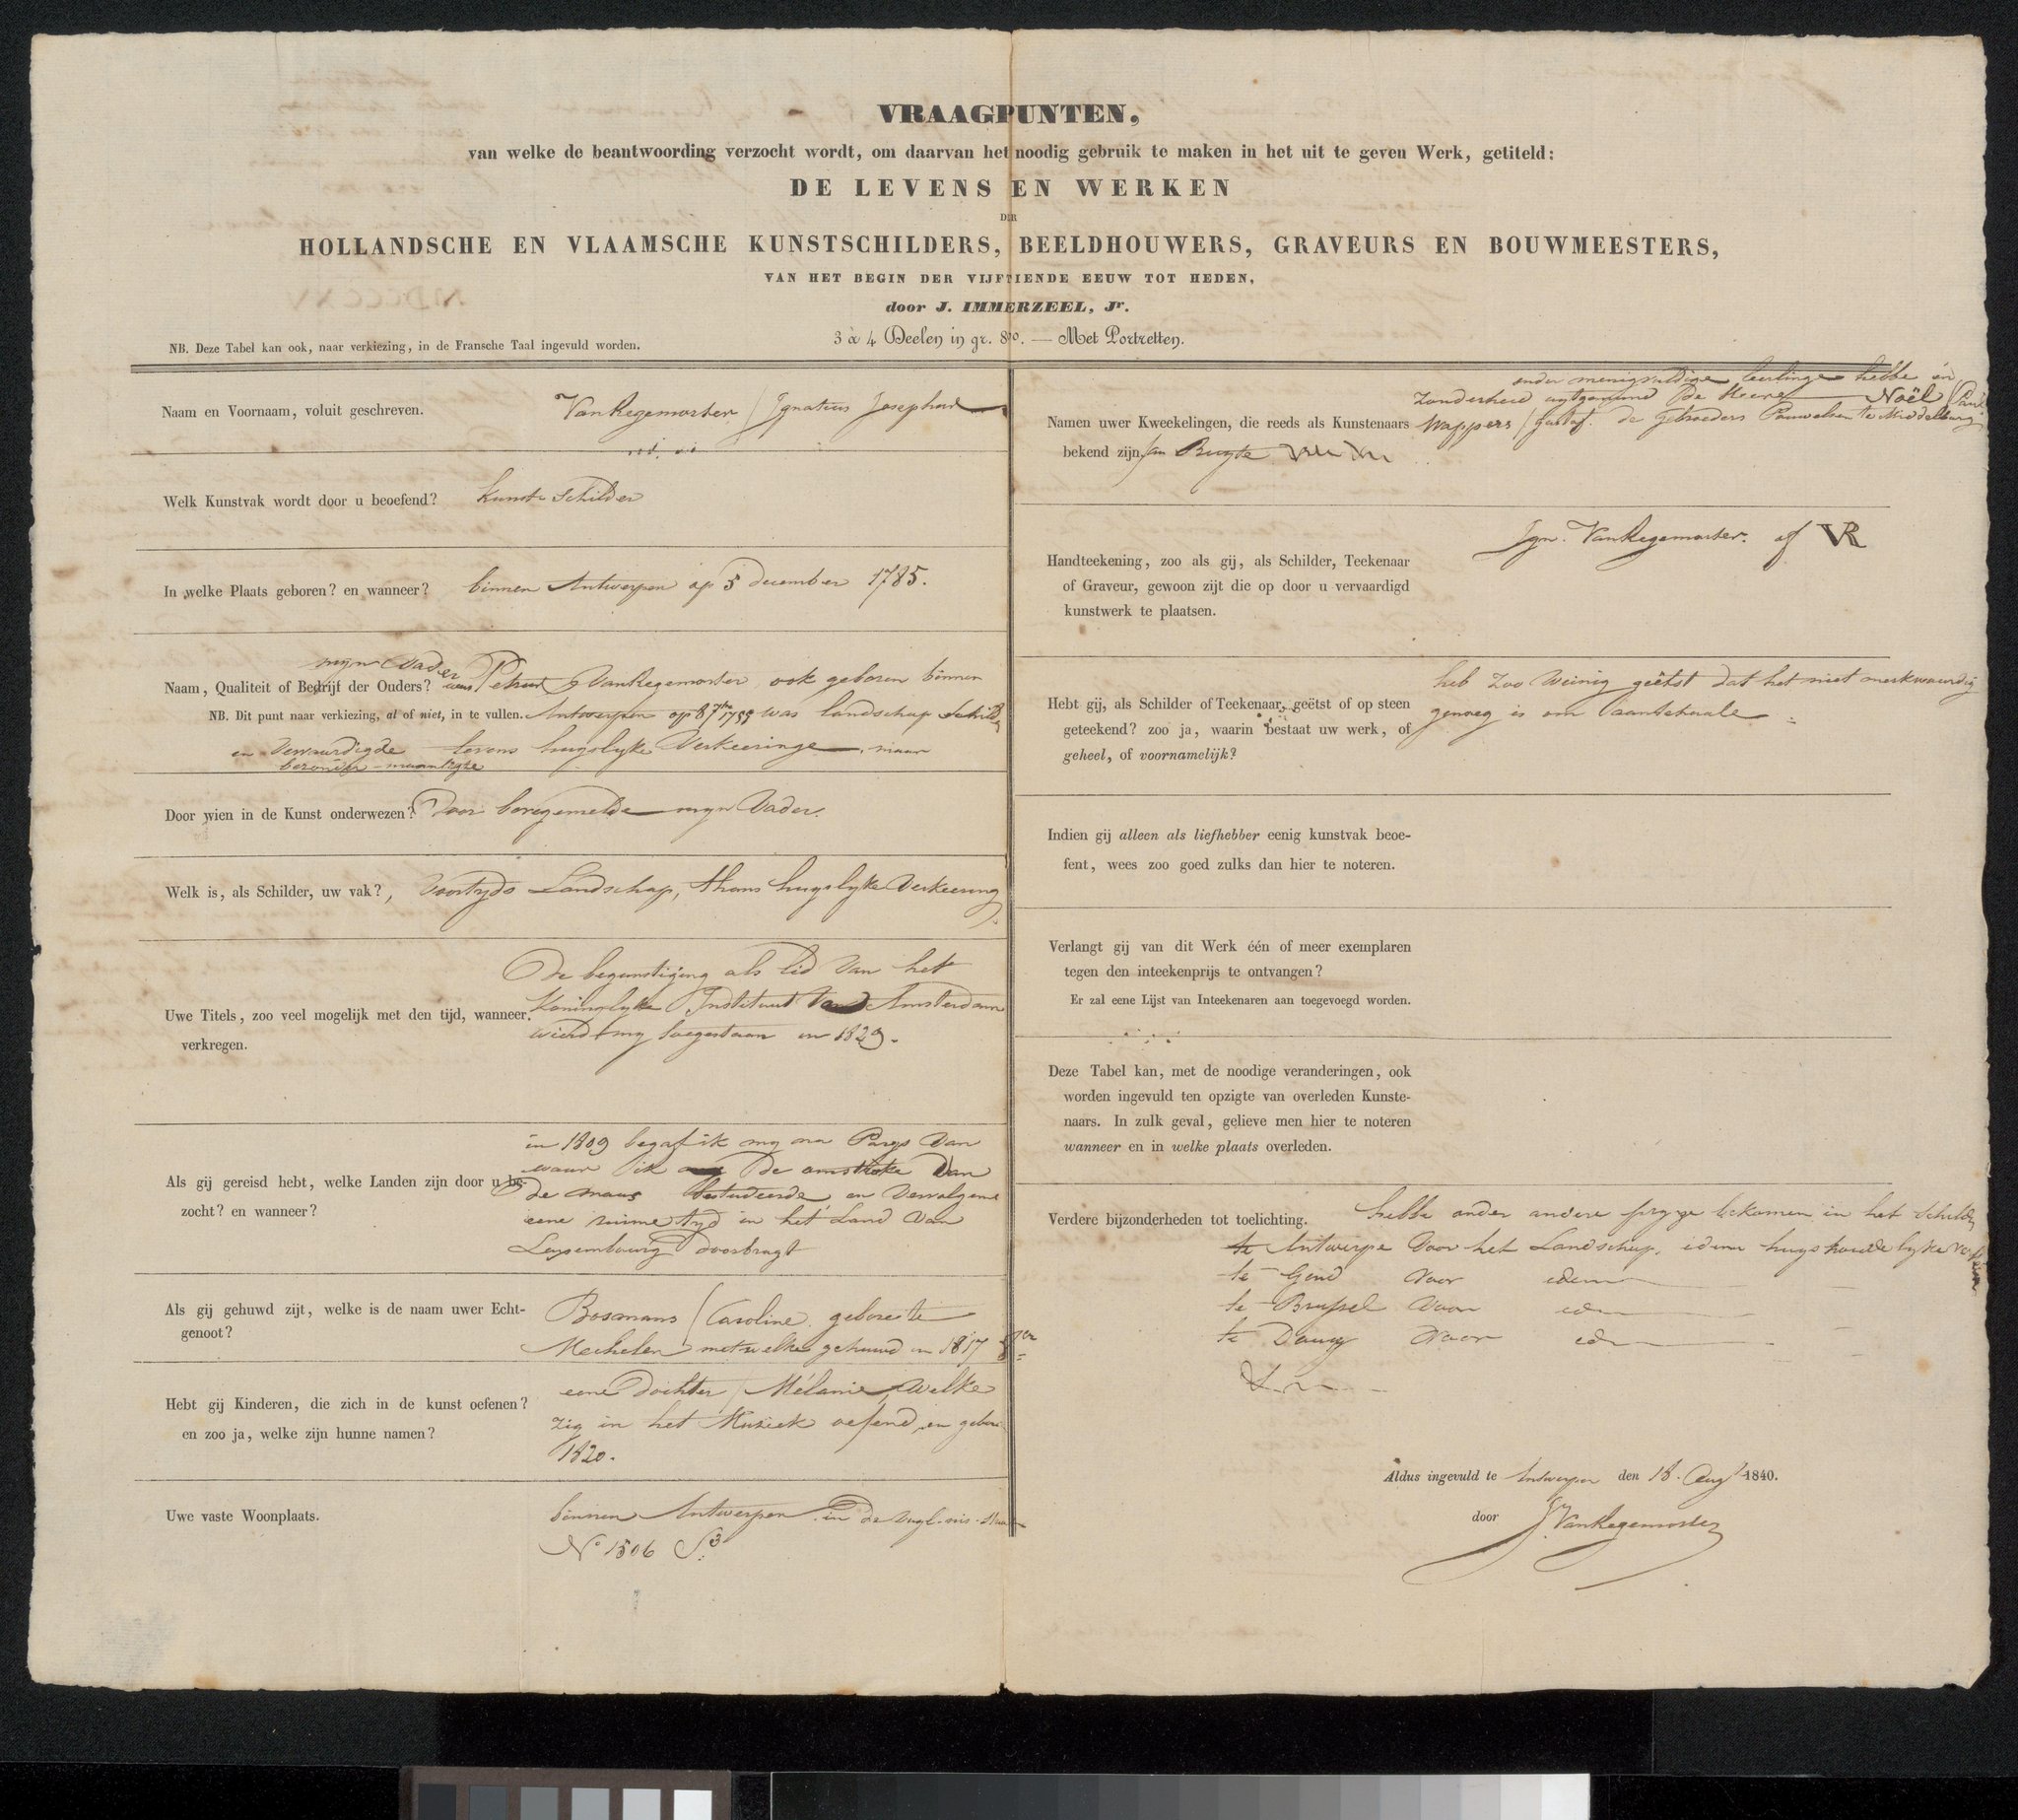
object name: questionnaire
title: Enquêteformulier ingevuld door Ignatius Josephus Van Regemorter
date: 1840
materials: ink, paper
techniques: pen, printing, writing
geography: antwerp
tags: antwerp, painter, print maker, conservator, ignatius josephus van regemorter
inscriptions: inscription: ‘Vraagpunten,/ van welke de beantwoording verzocht wordt, om daarvan het noodig gebruik te maken in het uit te geven Werk, getiteld: De levens en werken/ der Hollandsche en Vlaamsche kunstschilders, beeldhouwers,/ graveurs en bouwmeesters, van het begin der vijftiende eeuw tot heden/ door J. Immerzeel, Jr.’, watermark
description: Opgenomen in: Immerzeel, J. Jr., De levens en werken der Hollandsche en Vlaamsche kunstschilders, beeldhouwers, graveurs en bouwmeesters, van het begin der vijftiende eeuw tot heden, Amsterdam: J.C. van Kesteren, 1842-1843.